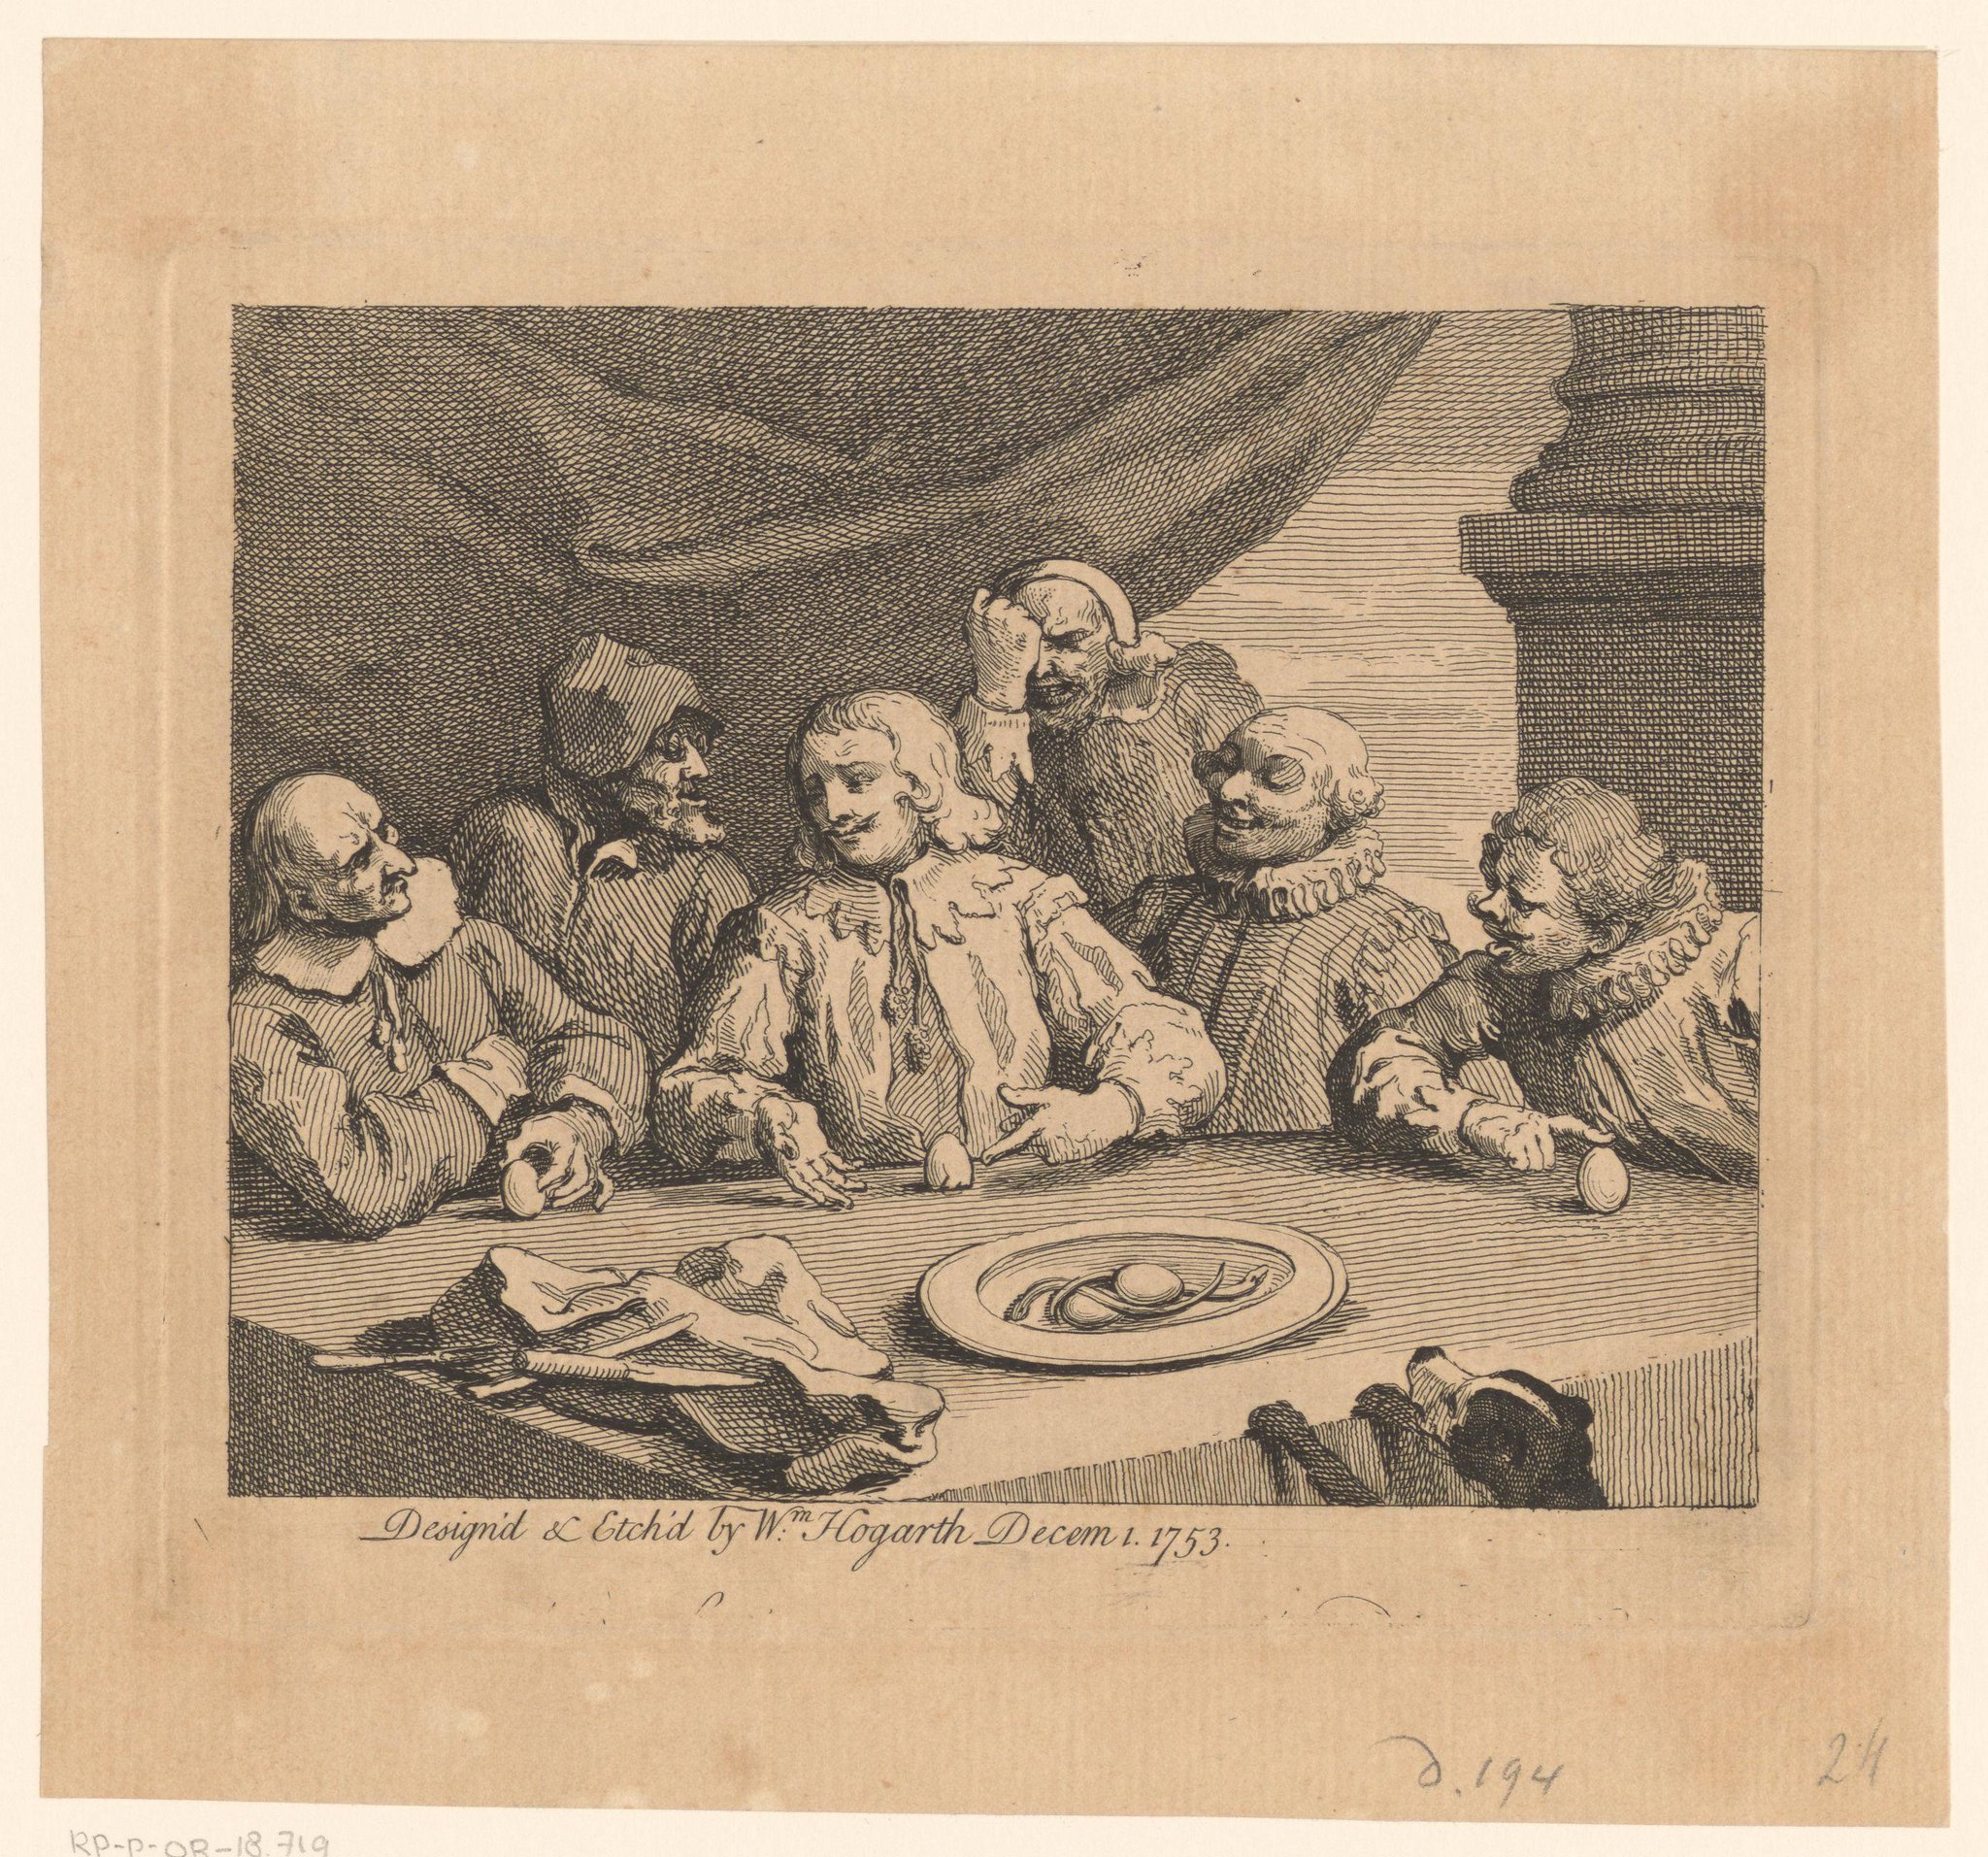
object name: print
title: Ei van Columbus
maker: william hogarth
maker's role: draughtsman, painter, print maker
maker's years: 1697-1764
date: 1753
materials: paper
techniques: engraving, etching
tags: historical persons, arrival and return ~ travelling, ingenuity; 'ingegno' (ripa)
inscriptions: collector's mark: Lugt 2228